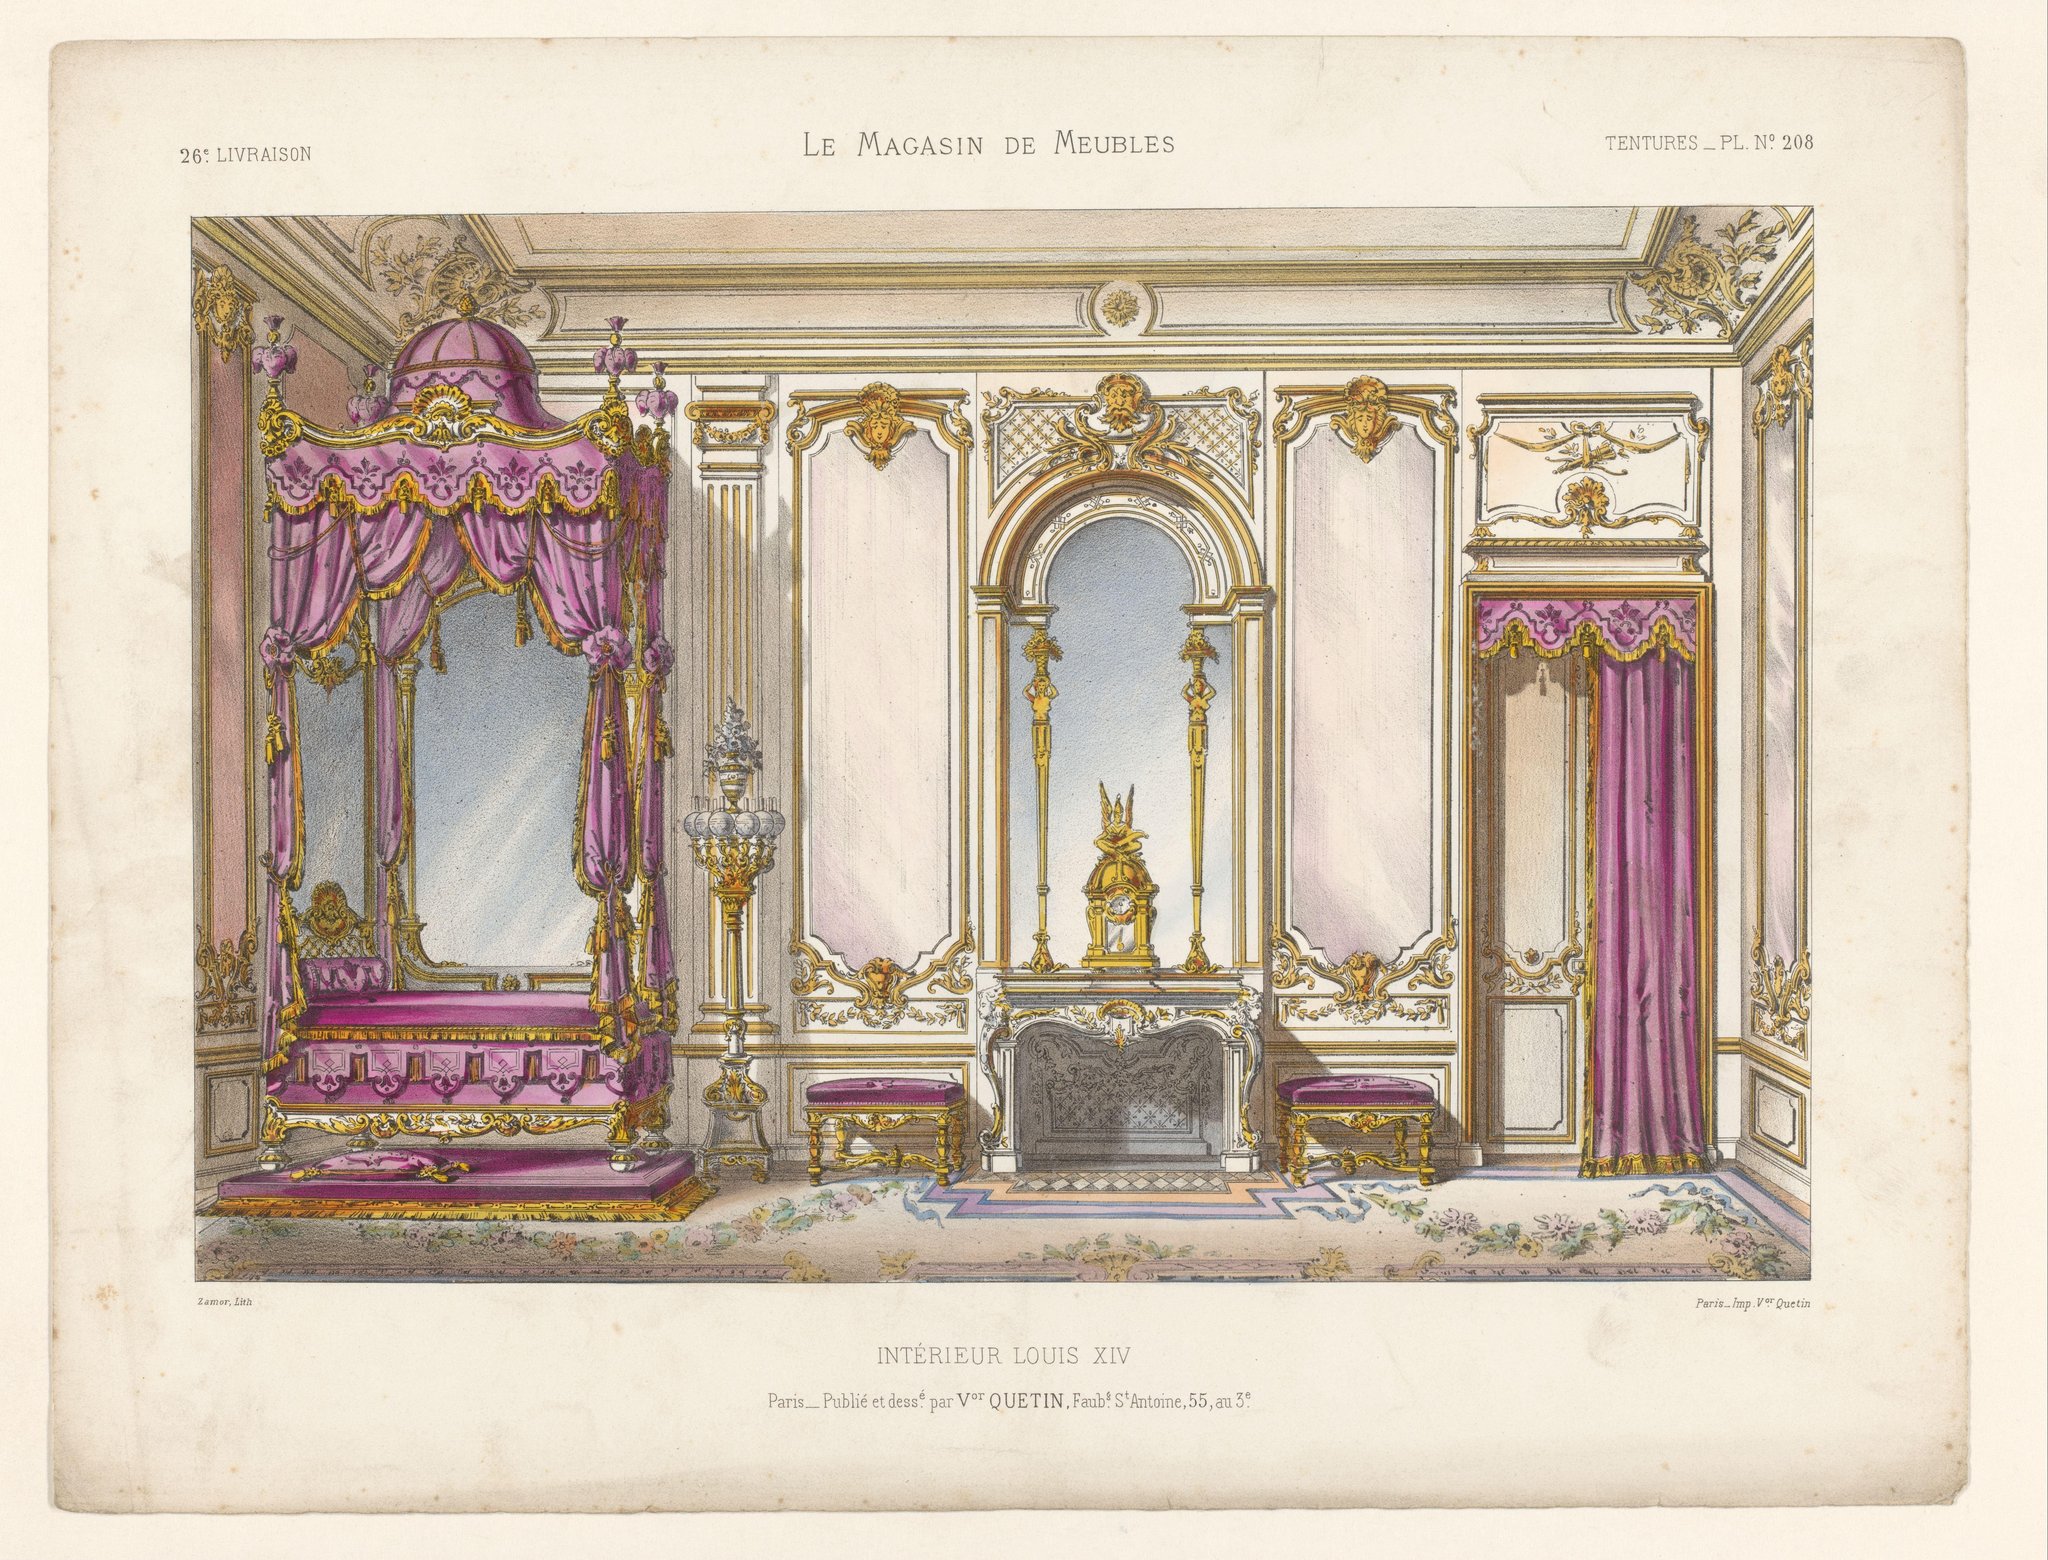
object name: print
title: Interieur met hemelbed en schouw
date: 1832-1877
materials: paper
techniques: hand coloring, lithograph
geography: paris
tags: interior of the house, hangings and drapery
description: Een interieur met hemelbed met draperieën, een schouw en een deur met gedrapeerde gordijnen in de Lodewijk XIV-stijl. Prent uit 26e Livraison.